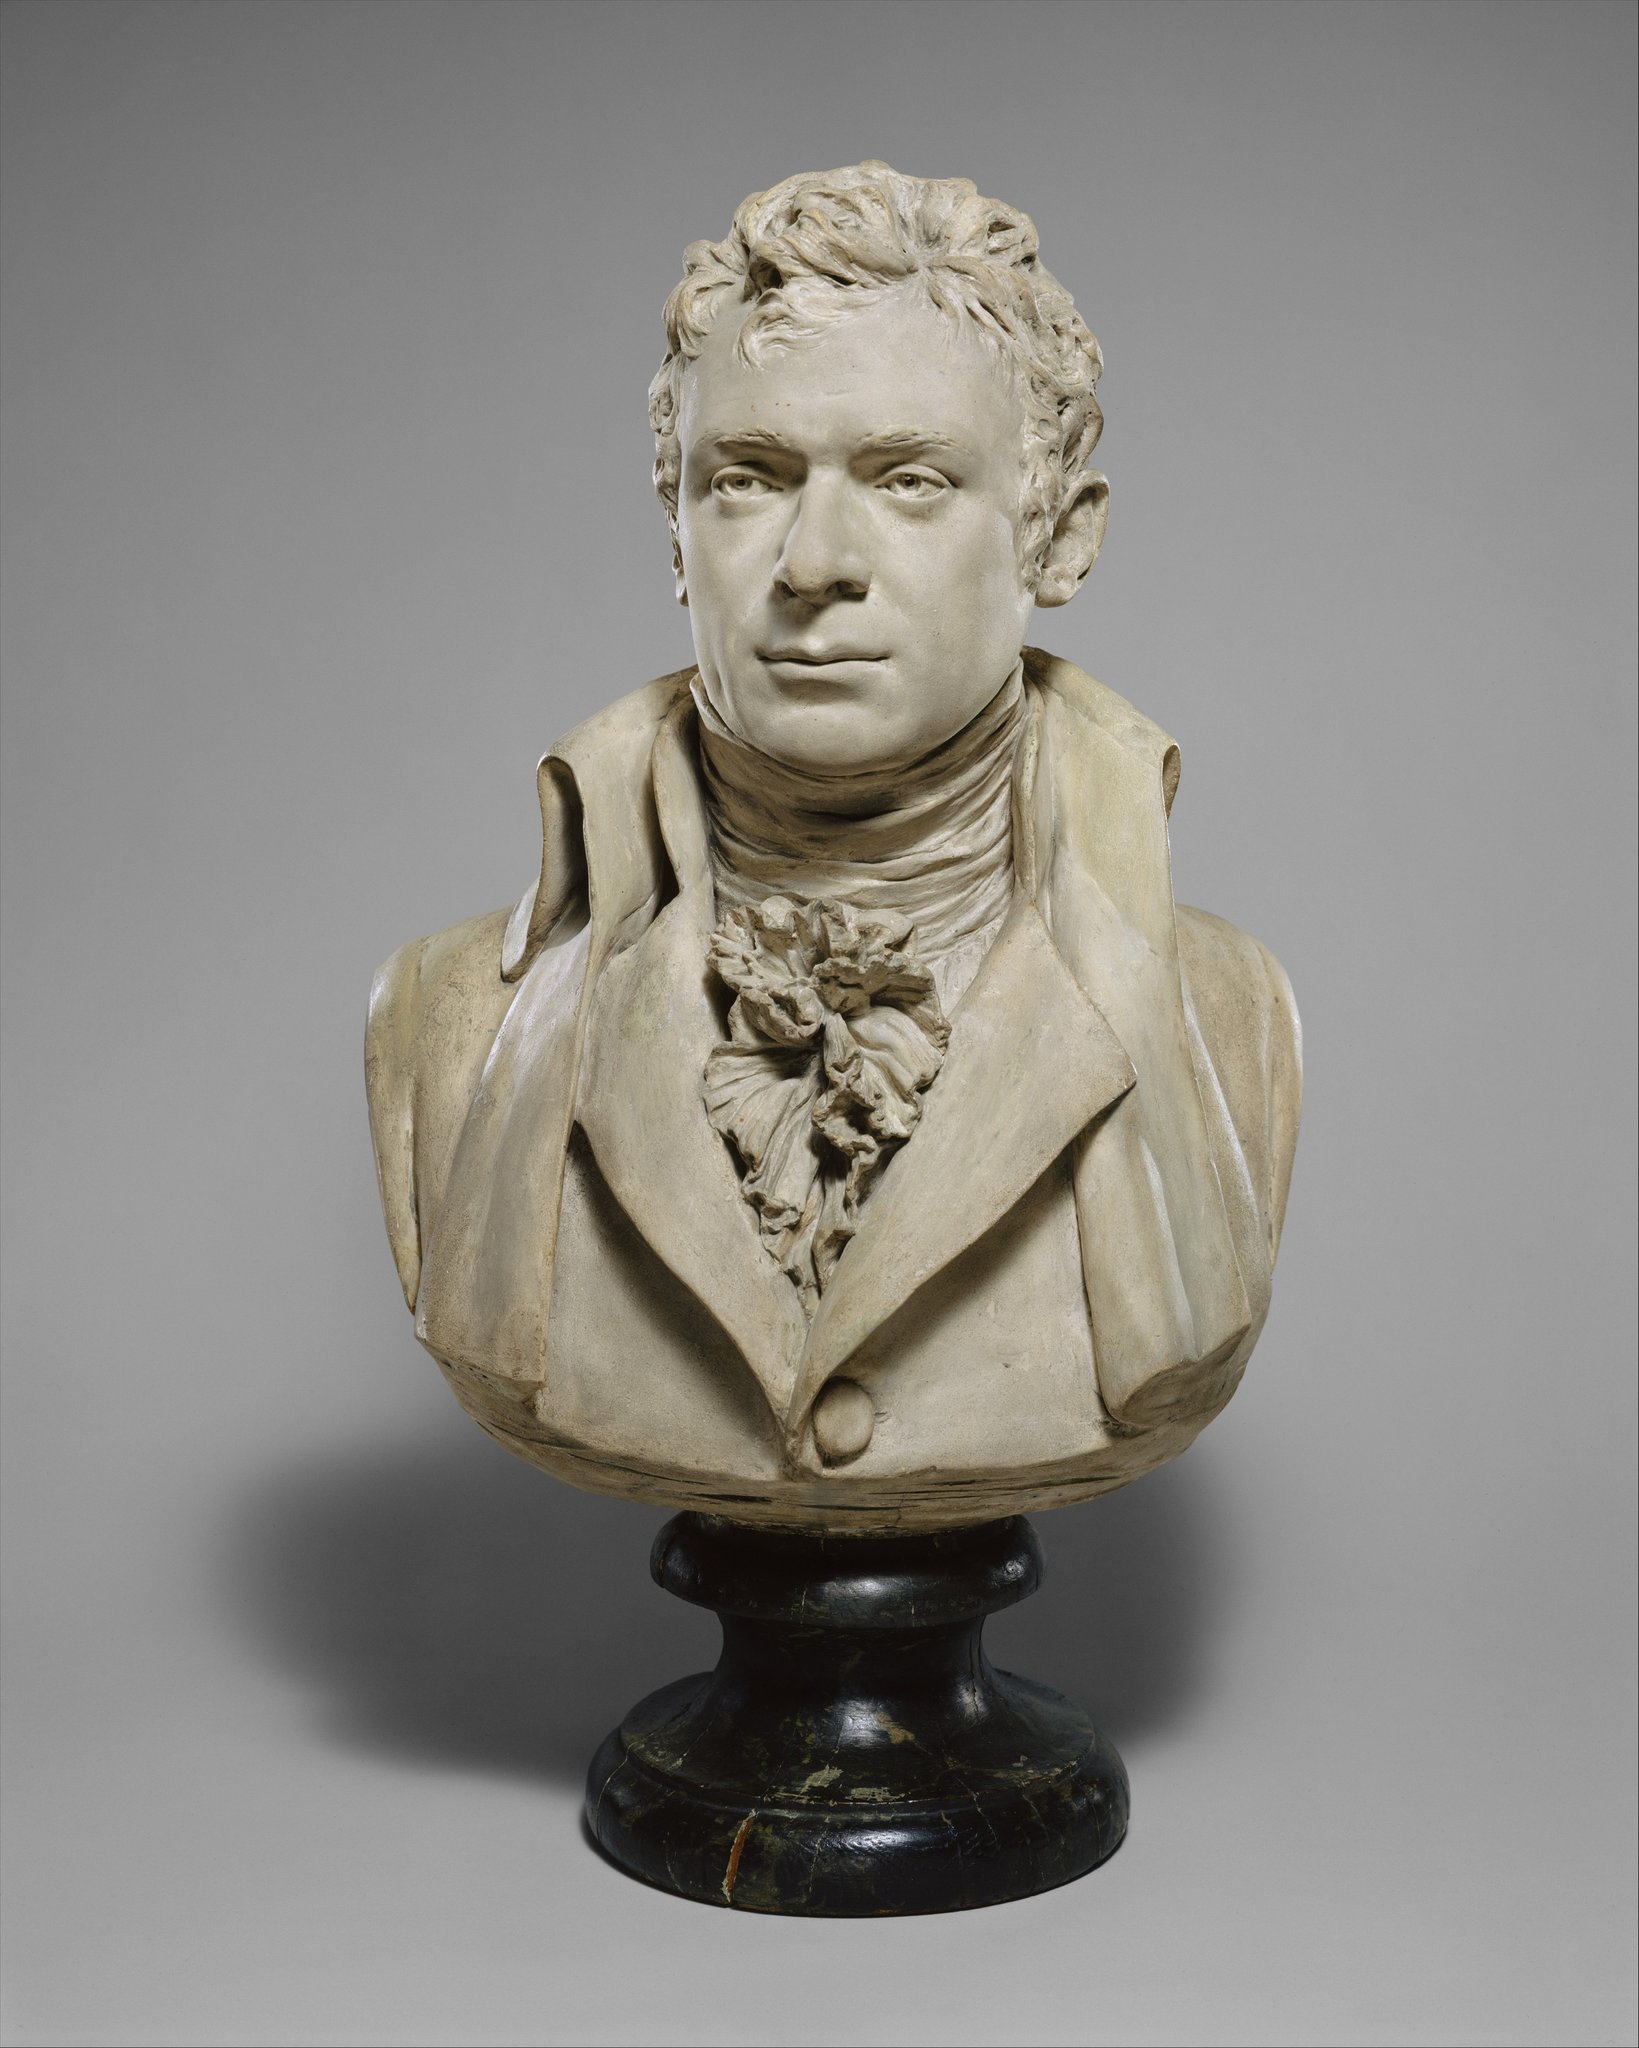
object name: bust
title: Robert Fulton (1765–1815)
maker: jean antoine houdon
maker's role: artist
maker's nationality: french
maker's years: 1741-1828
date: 1803-1804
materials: plaster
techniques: painting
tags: men,portraits